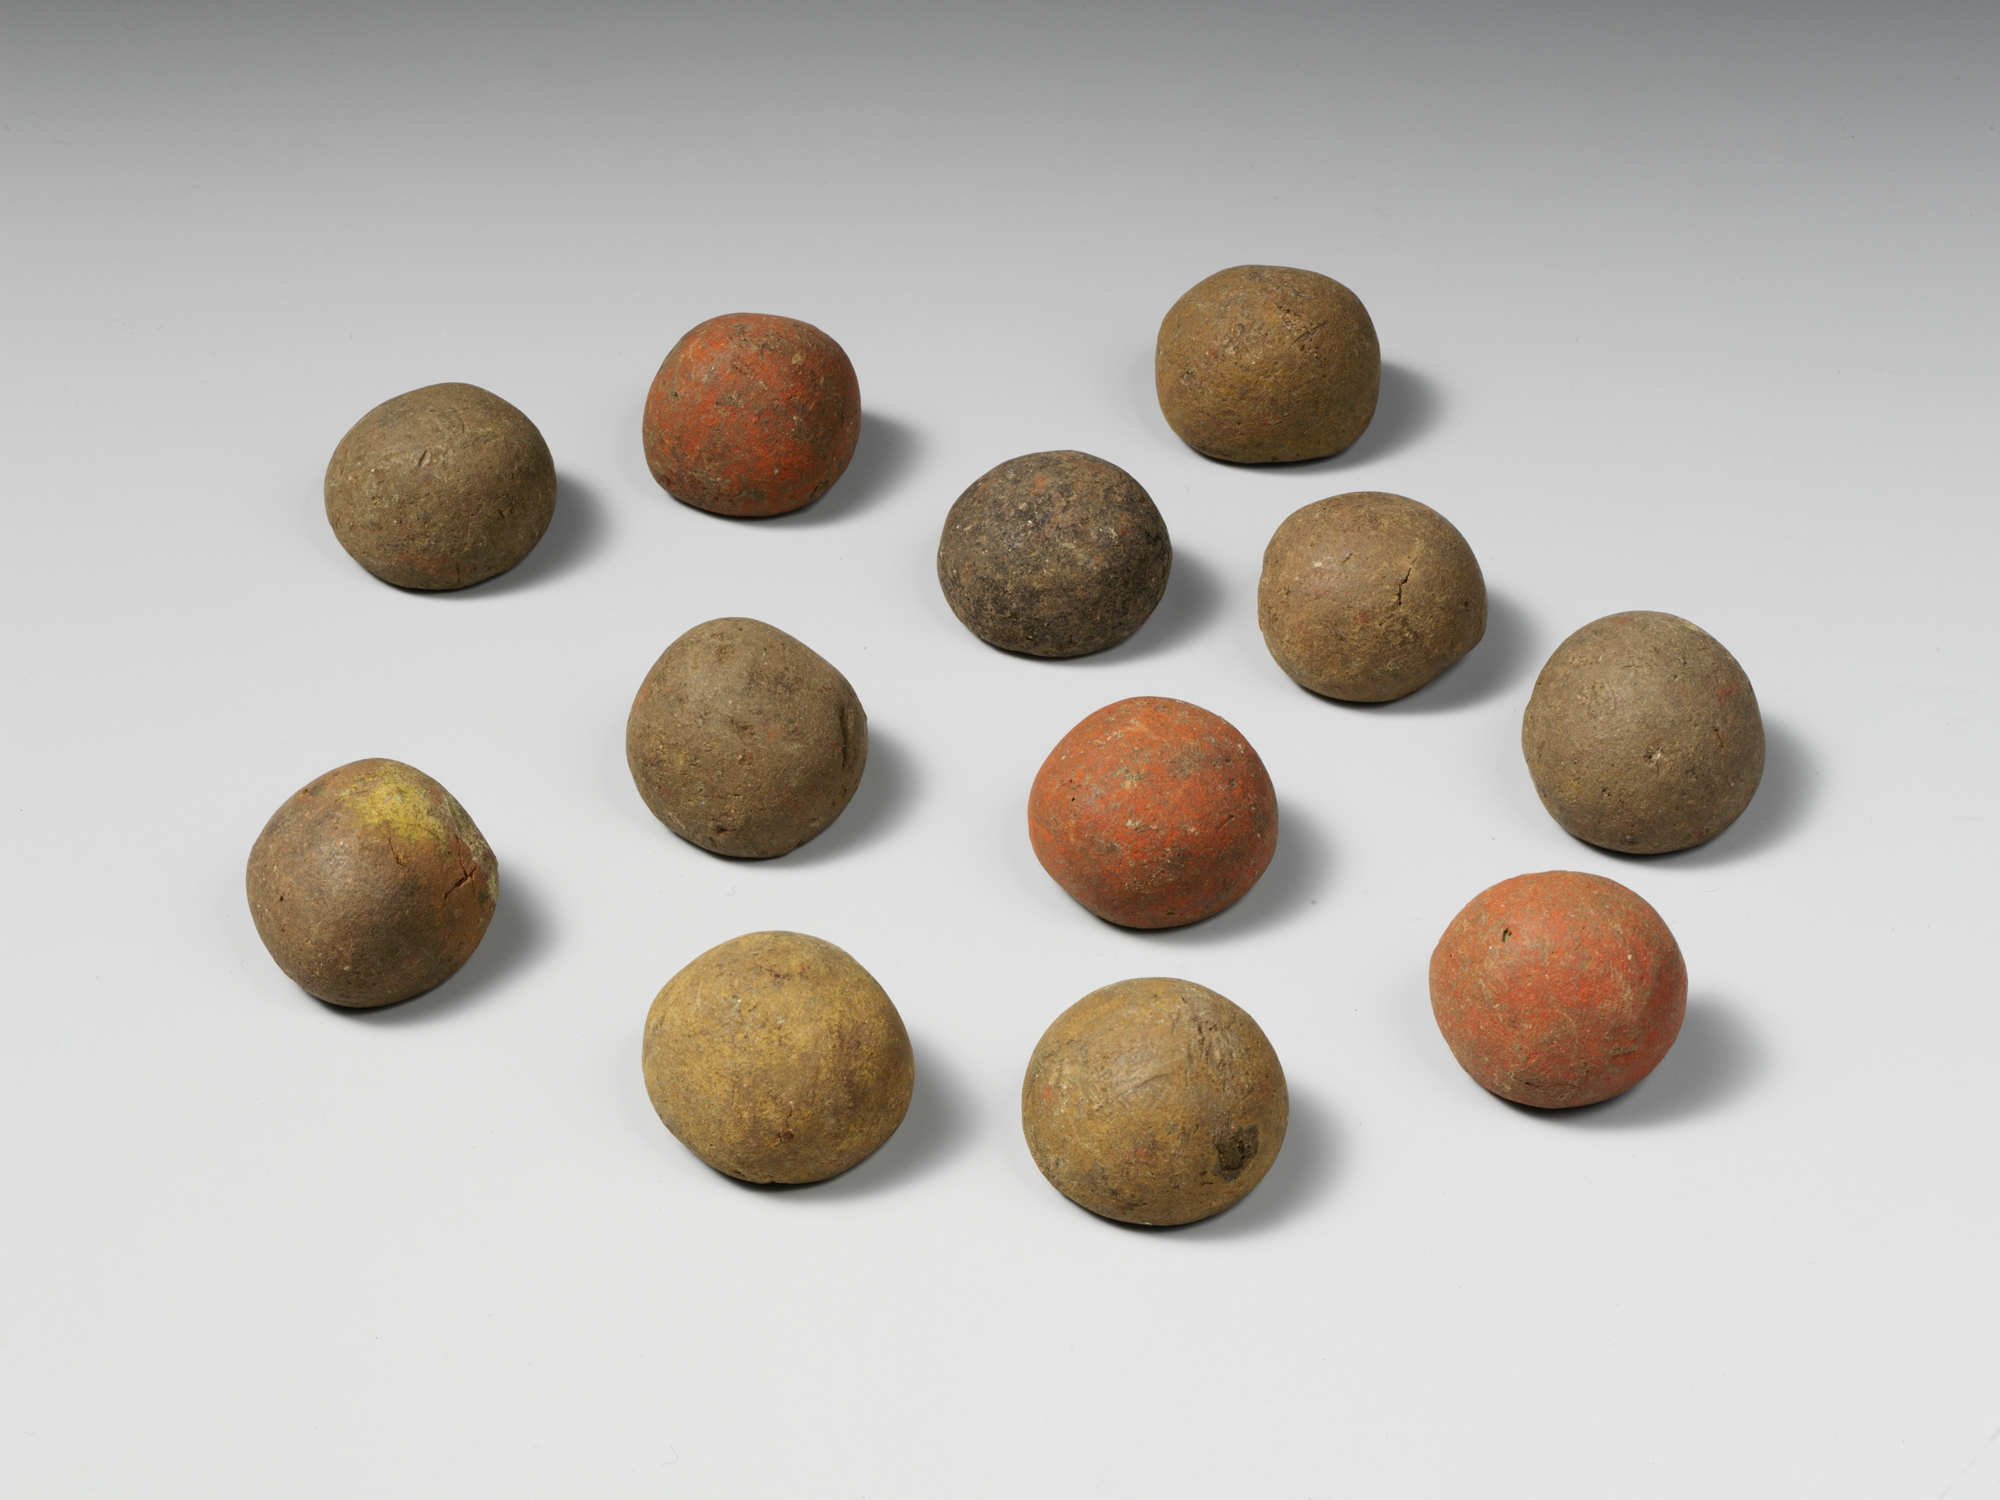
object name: ball, 12 for a game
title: Set of twelve red terracotta balls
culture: etruscan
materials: terracotta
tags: games